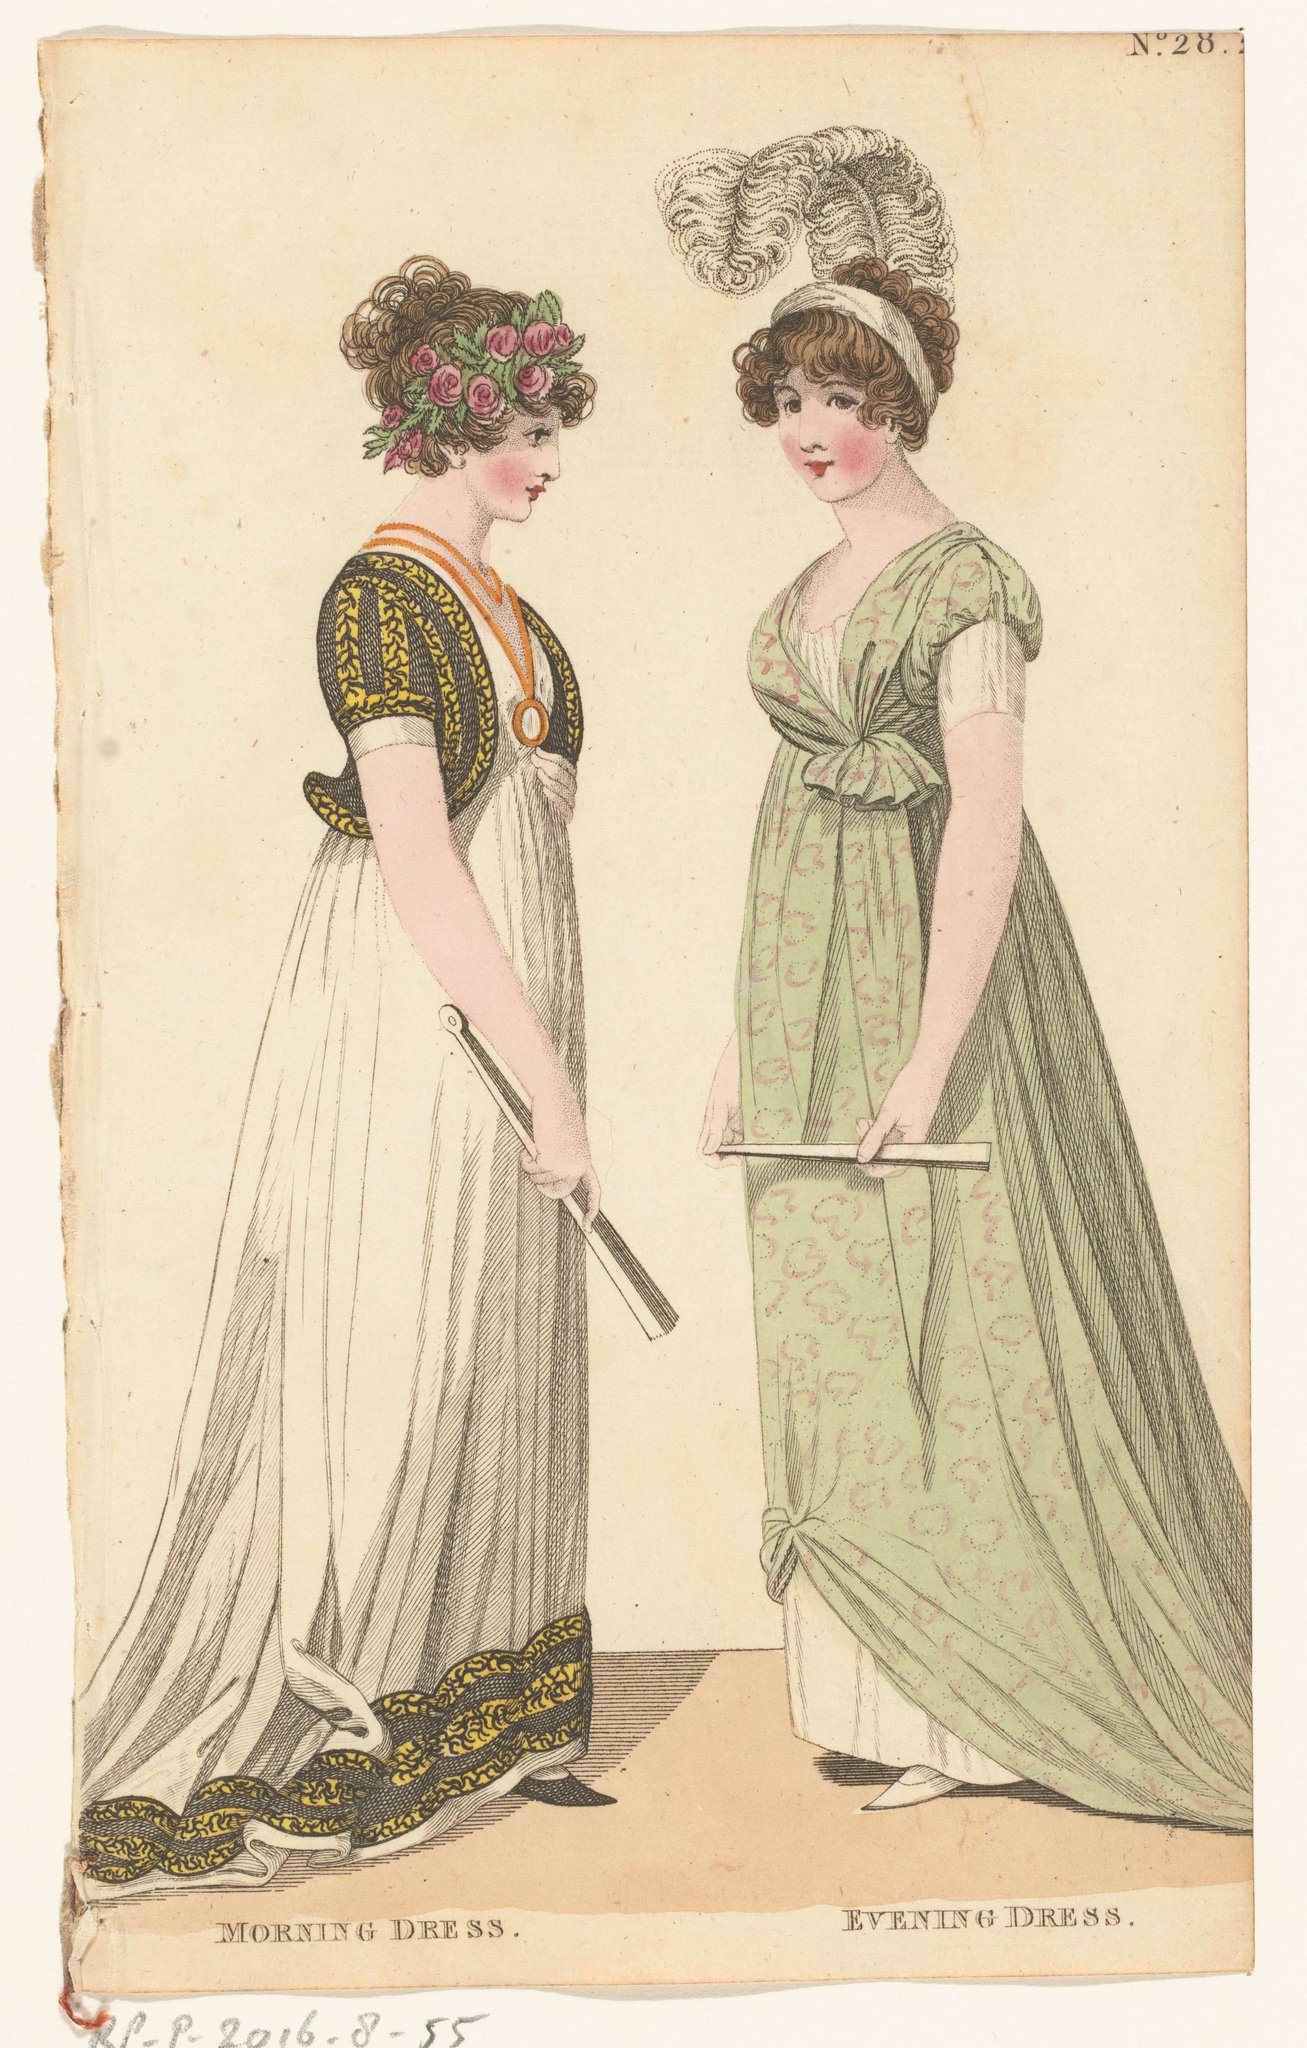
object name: fashion print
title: Magazine of Female Fashions of London and Paris, No. 28: Morning Dress; Evening Dress.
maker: richard phillips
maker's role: bookseller, publisher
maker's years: 1767-1840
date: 1798-1806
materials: paper, ink, watercolor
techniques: engraving, etching, hand coloring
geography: london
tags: pendant, trinket, 'breloque' (+ women's clothes), dress, gown: evening dress (+ women's clothes), dress, gown: morning dress (+ women's clothes), fashion plates, fan (+ women's clothes)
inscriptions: collector's mark: Lugt 2228, : ‘Morning Dress / Evening Dress’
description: Links een vrouw in ochtendjapon, bloemenkrans op het hoofd; rechts een vrouw in avondjapon, hoofdband met grote veer. Beiden hebben een dichtgeklapte waaier in de hand.